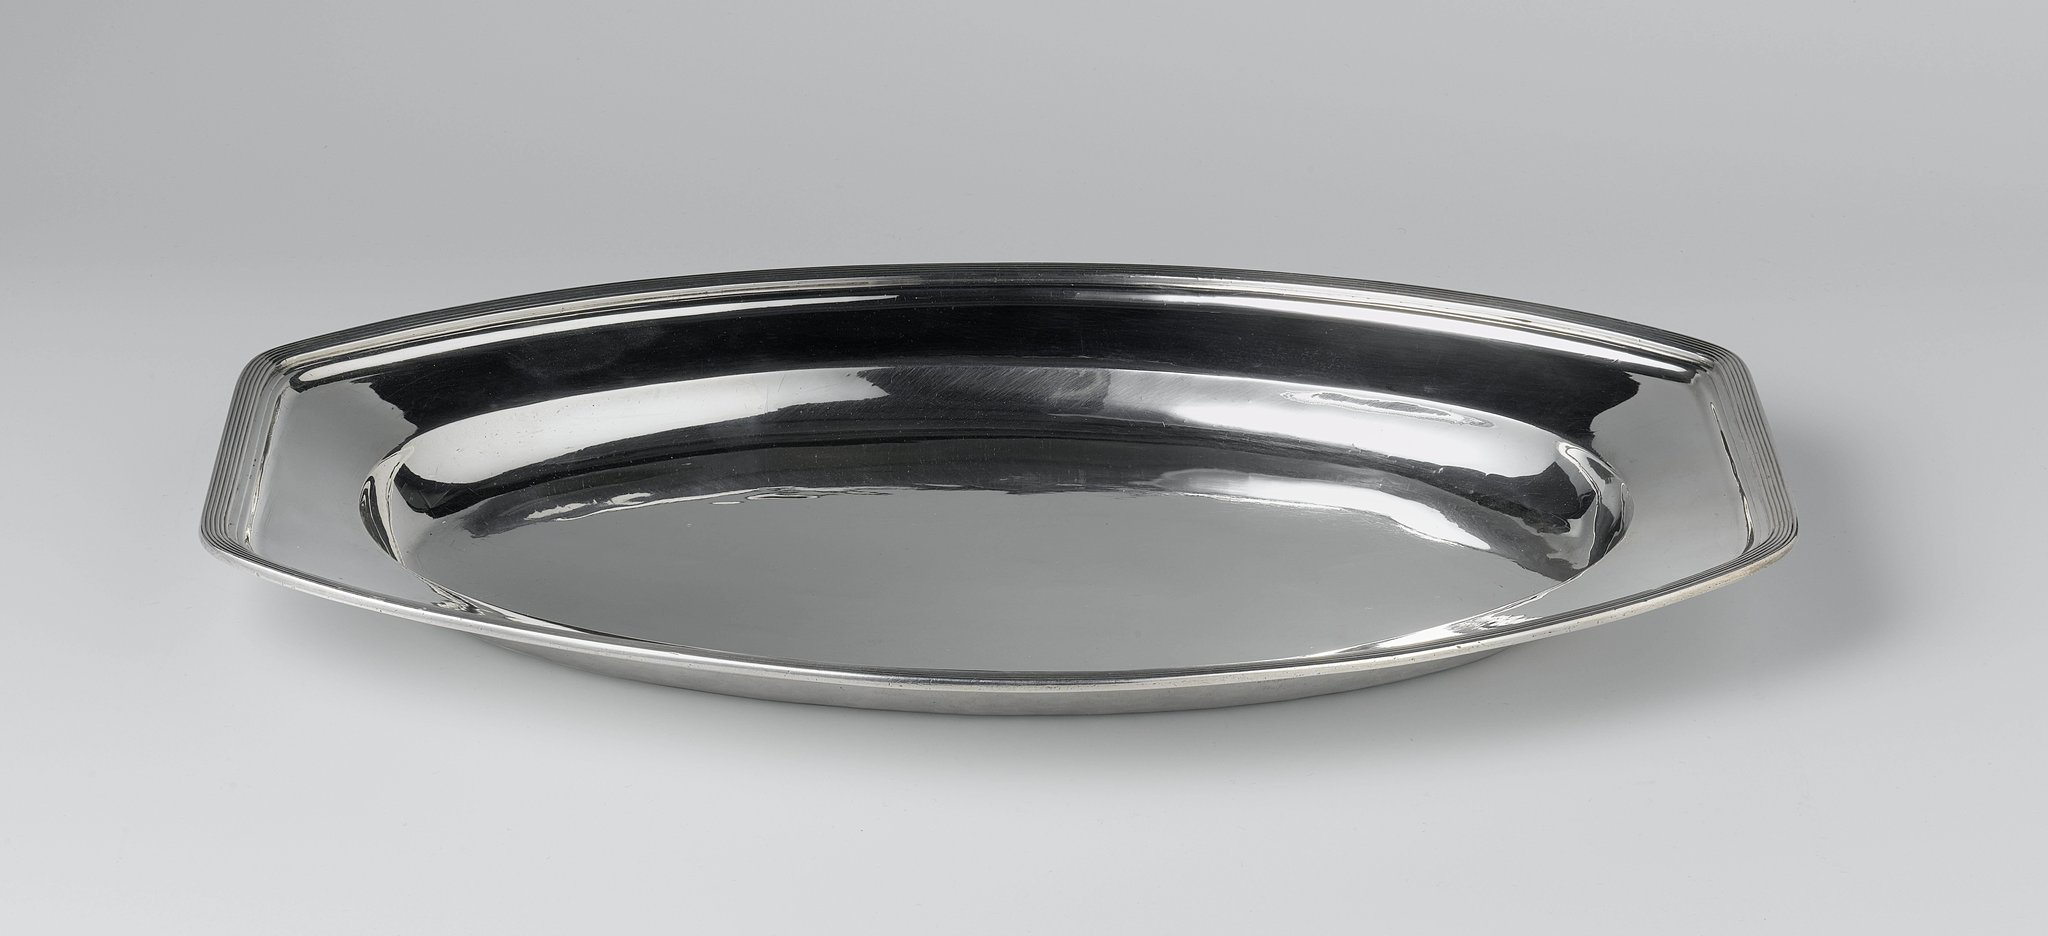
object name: platter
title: Parts of the Silver Dinner Service for the Prince of Orange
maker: hendrik smits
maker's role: silversmith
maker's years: 1772-1841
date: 1816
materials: silver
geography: amsterdam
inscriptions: retailer's mark: ‘DIEMONT’, assay office mark, alloy mark, maker's mark, date letter: ‘G’, assayer's mark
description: William Prince of Orange (later William II) and the Russian grand duchess Anna Pavlovna were married in St Petersburg in 1816. Back in the Netherlands, they were showered with wedding gifts. The City of Amsterdam commissioned a 419-piece silver dinner service, a small part of which is on view here. The House of Orange family coat of arms features the Dutch lion. Most appropriately, the handles of the soup tureen are in the shape of lion heads.